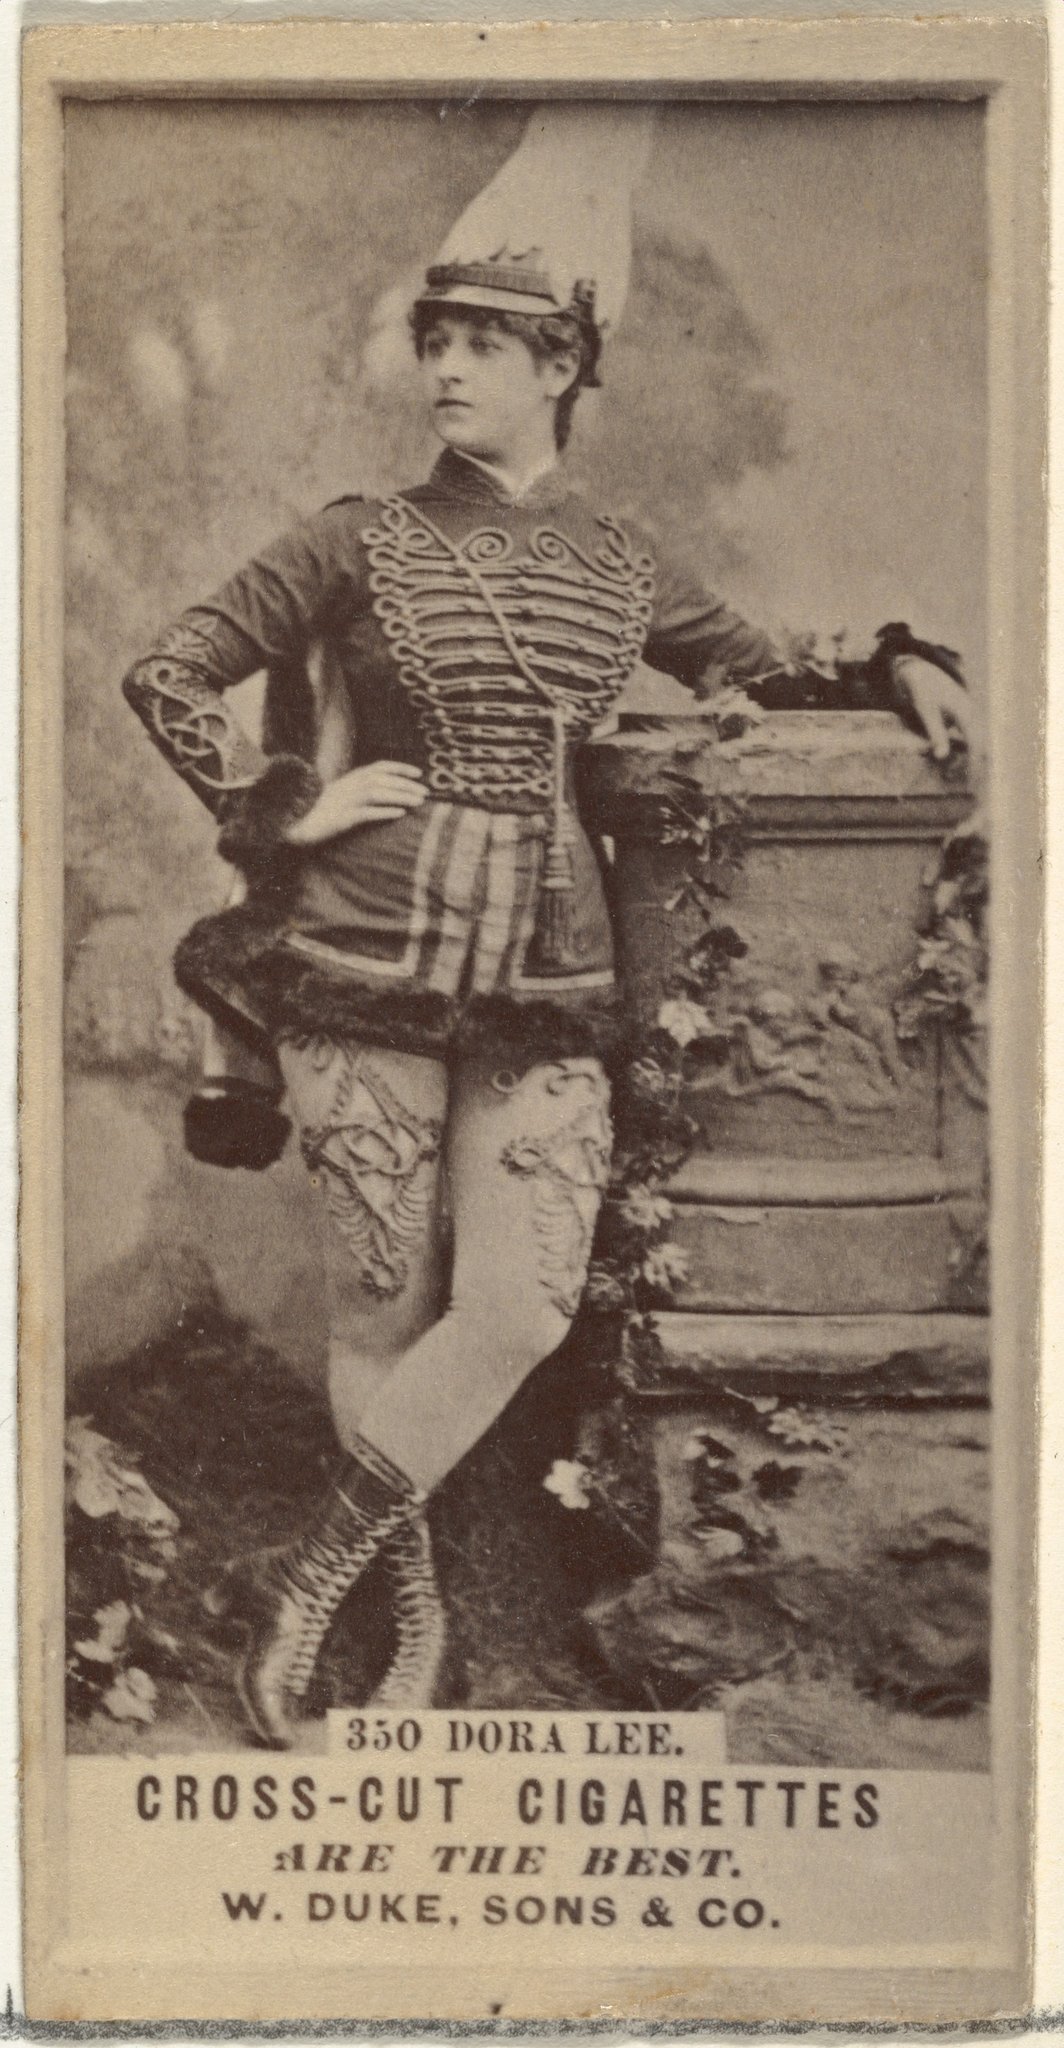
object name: photograph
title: Card Number 350, Dora Lee, from the Actors and Actresses series (N145-3) issued by Duke Sons & Co. to promote Cross Cut Cigarettes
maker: w. duke, sons & co.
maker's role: publisher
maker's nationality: american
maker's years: 1870-1920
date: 1880-1889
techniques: albumen silver print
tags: portraits,women,actresses